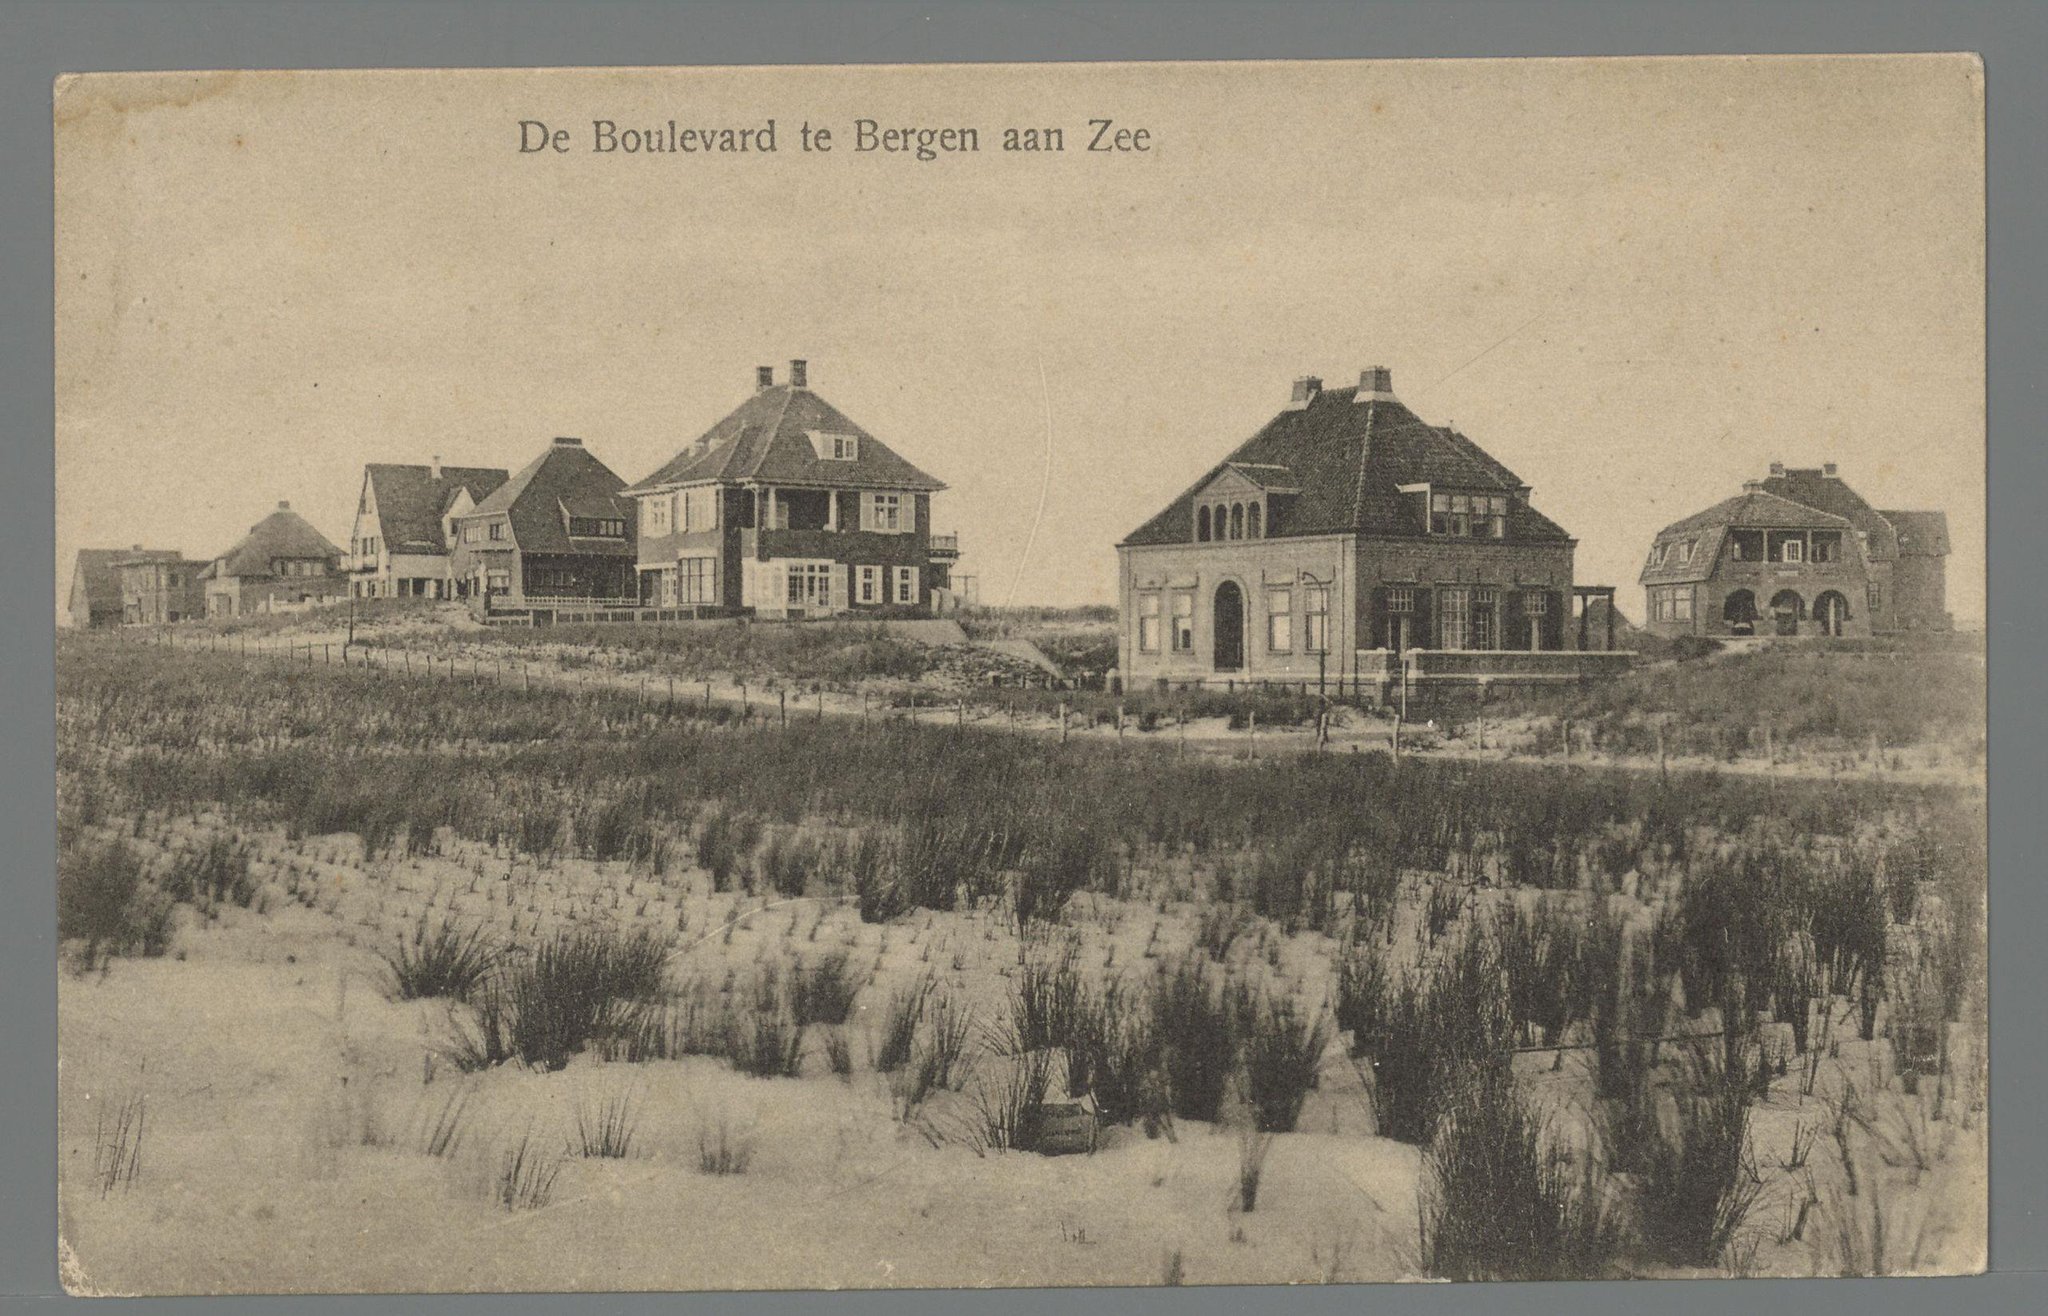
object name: ansichtkaart, prentbriefkaart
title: De Boulevard te Bergen aan Zee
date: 1925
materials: cardboard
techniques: photograph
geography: bergen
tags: dunes (sea not visible); in the dunes, rural housing, e.g. country-house, villa, cottage, avenue, boulevard, promenade, esplanade